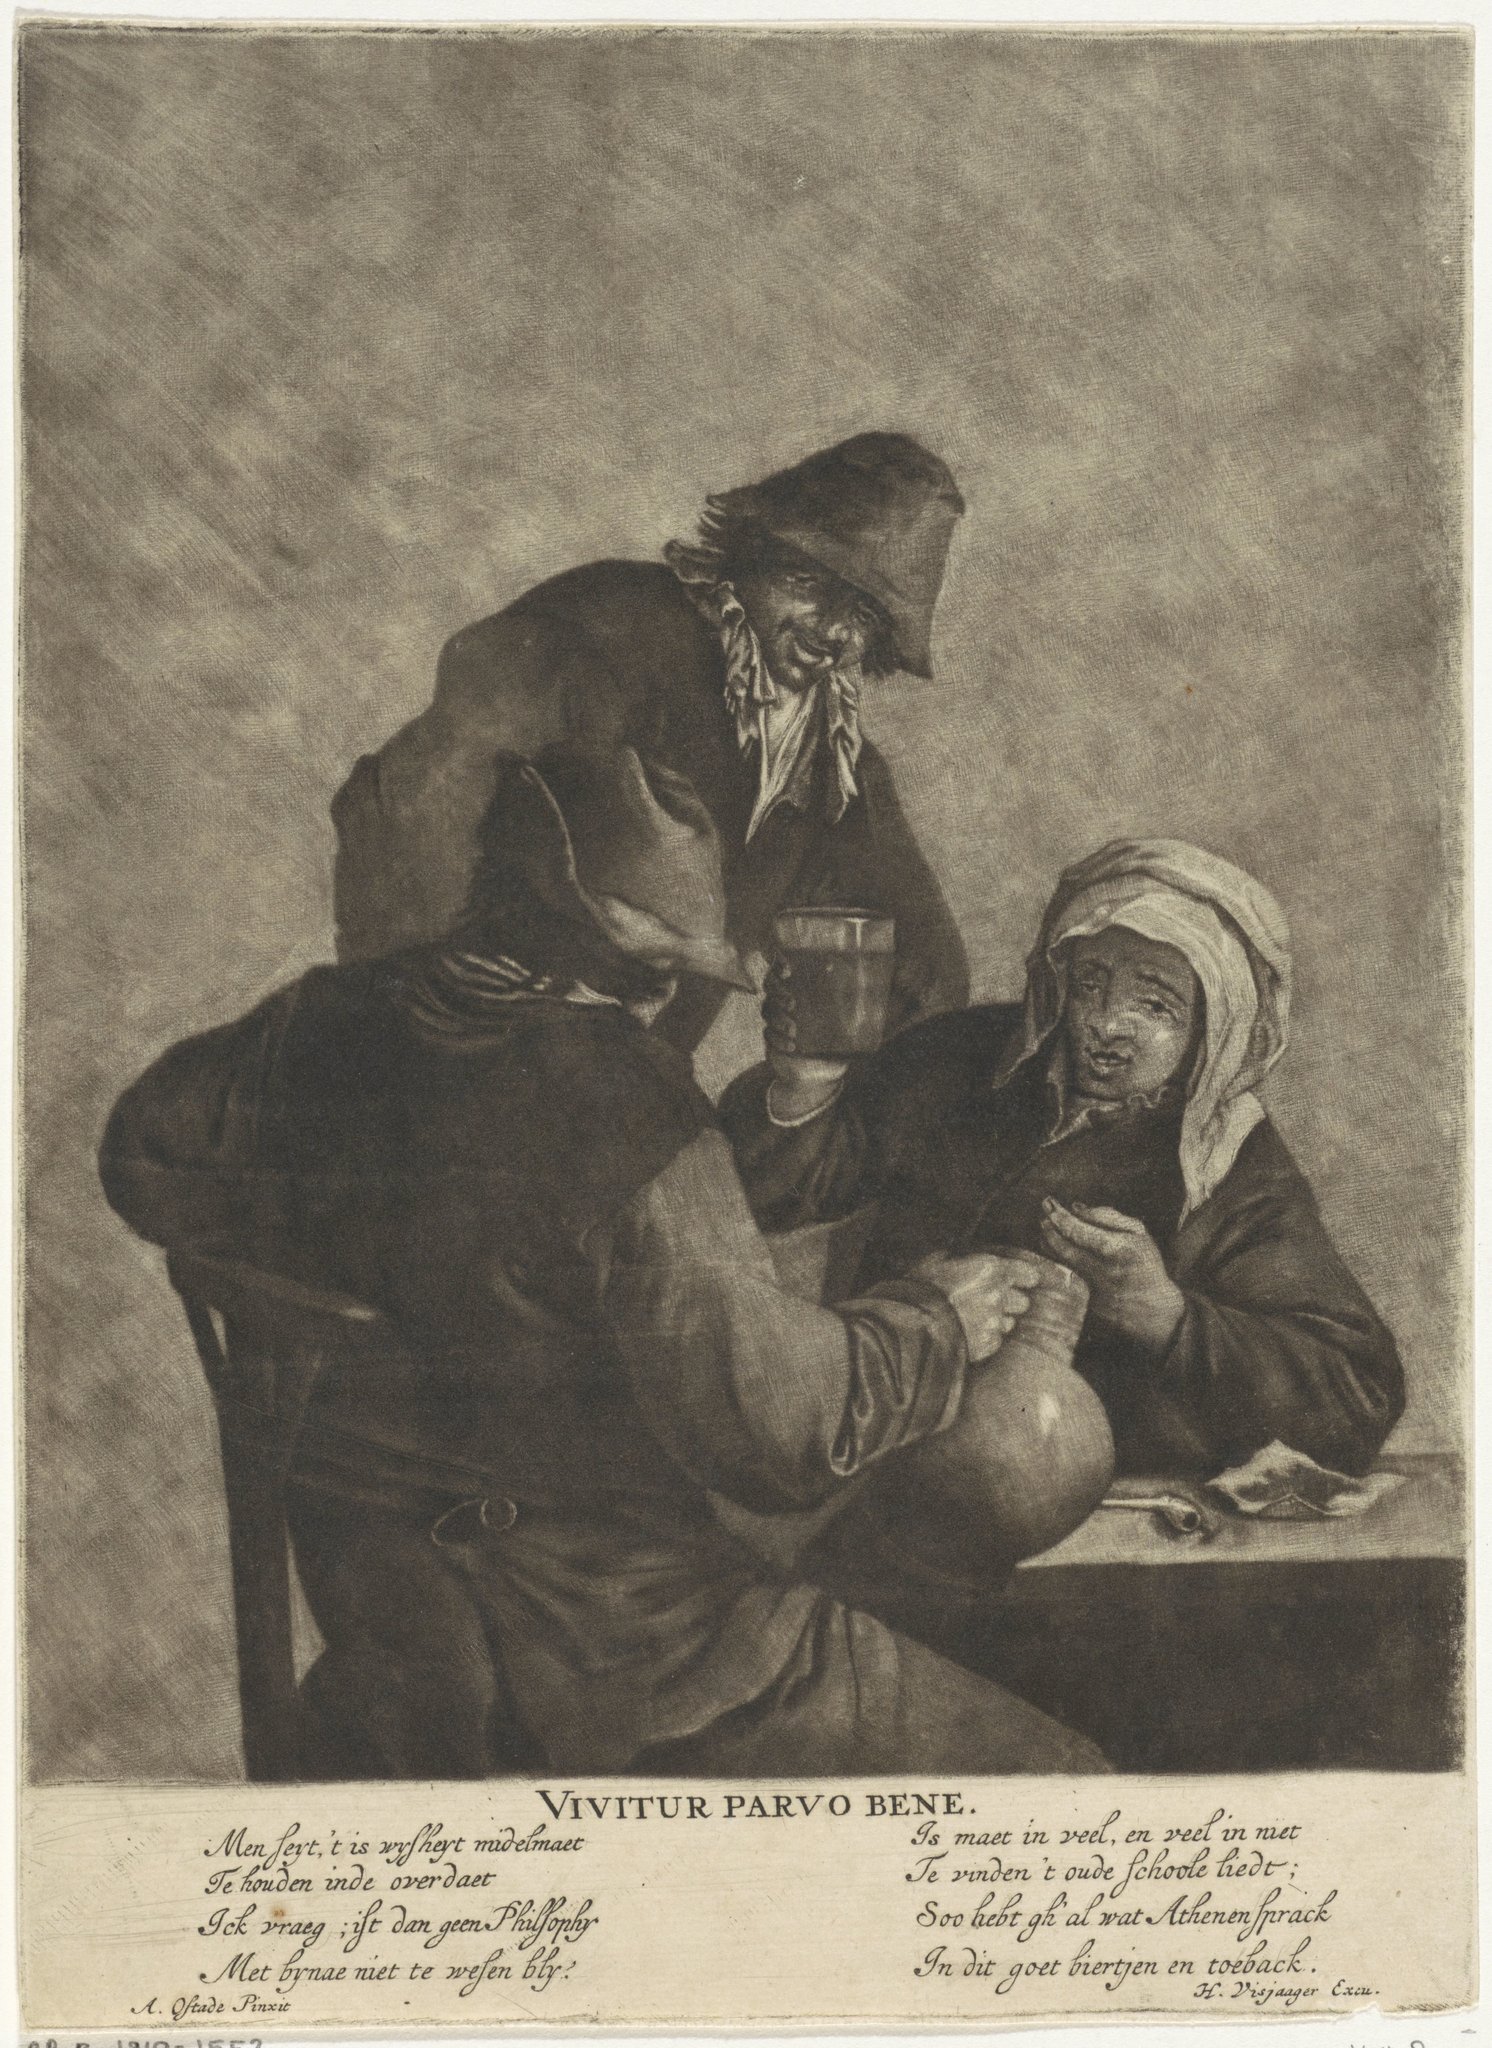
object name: print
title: Vivitur Parvo Bene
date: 1683-1684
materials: paper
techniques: mezzotint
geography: amsterdam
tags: pipe ~ tobacco, drinking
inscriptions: collector's mark: Lugt 2228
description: Drie drinkers bij een tafel. Een van hen heft het glas, een andere, op de rug gezien, houdt een bierkan in de hand. Op de tafel liggen een pijp en tabak.